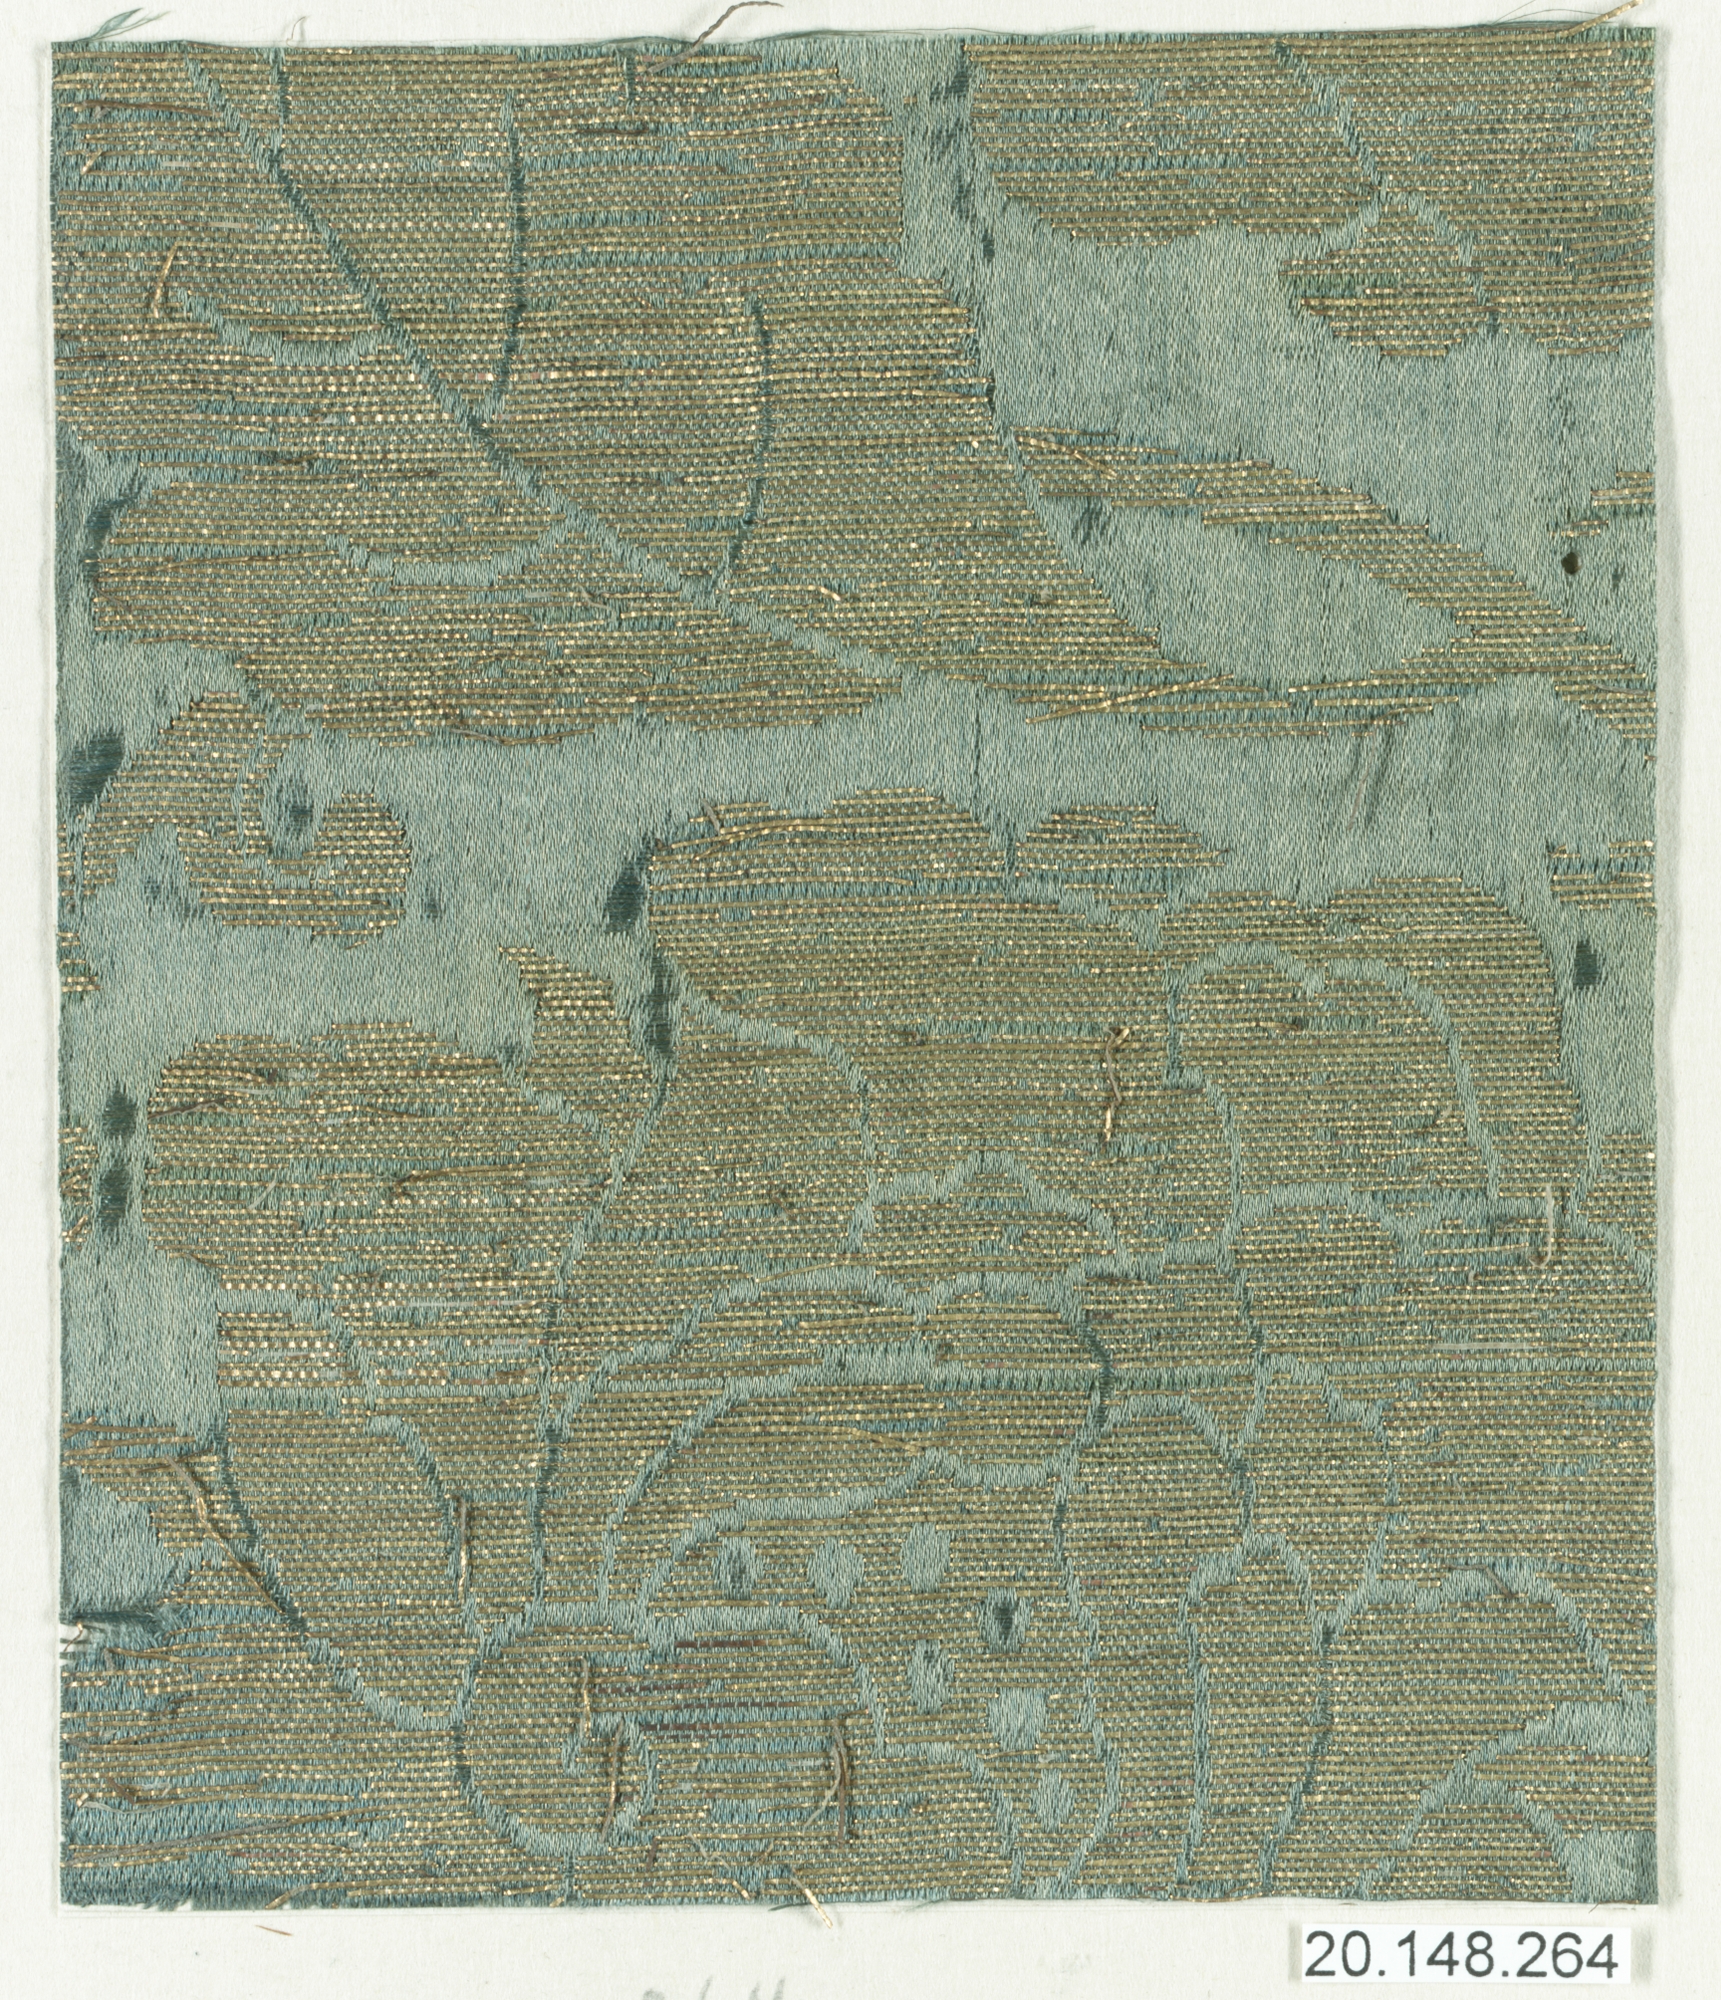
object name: piece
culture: japanese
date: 1701-1800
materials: silk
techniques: compound weave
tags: flowers,leaves